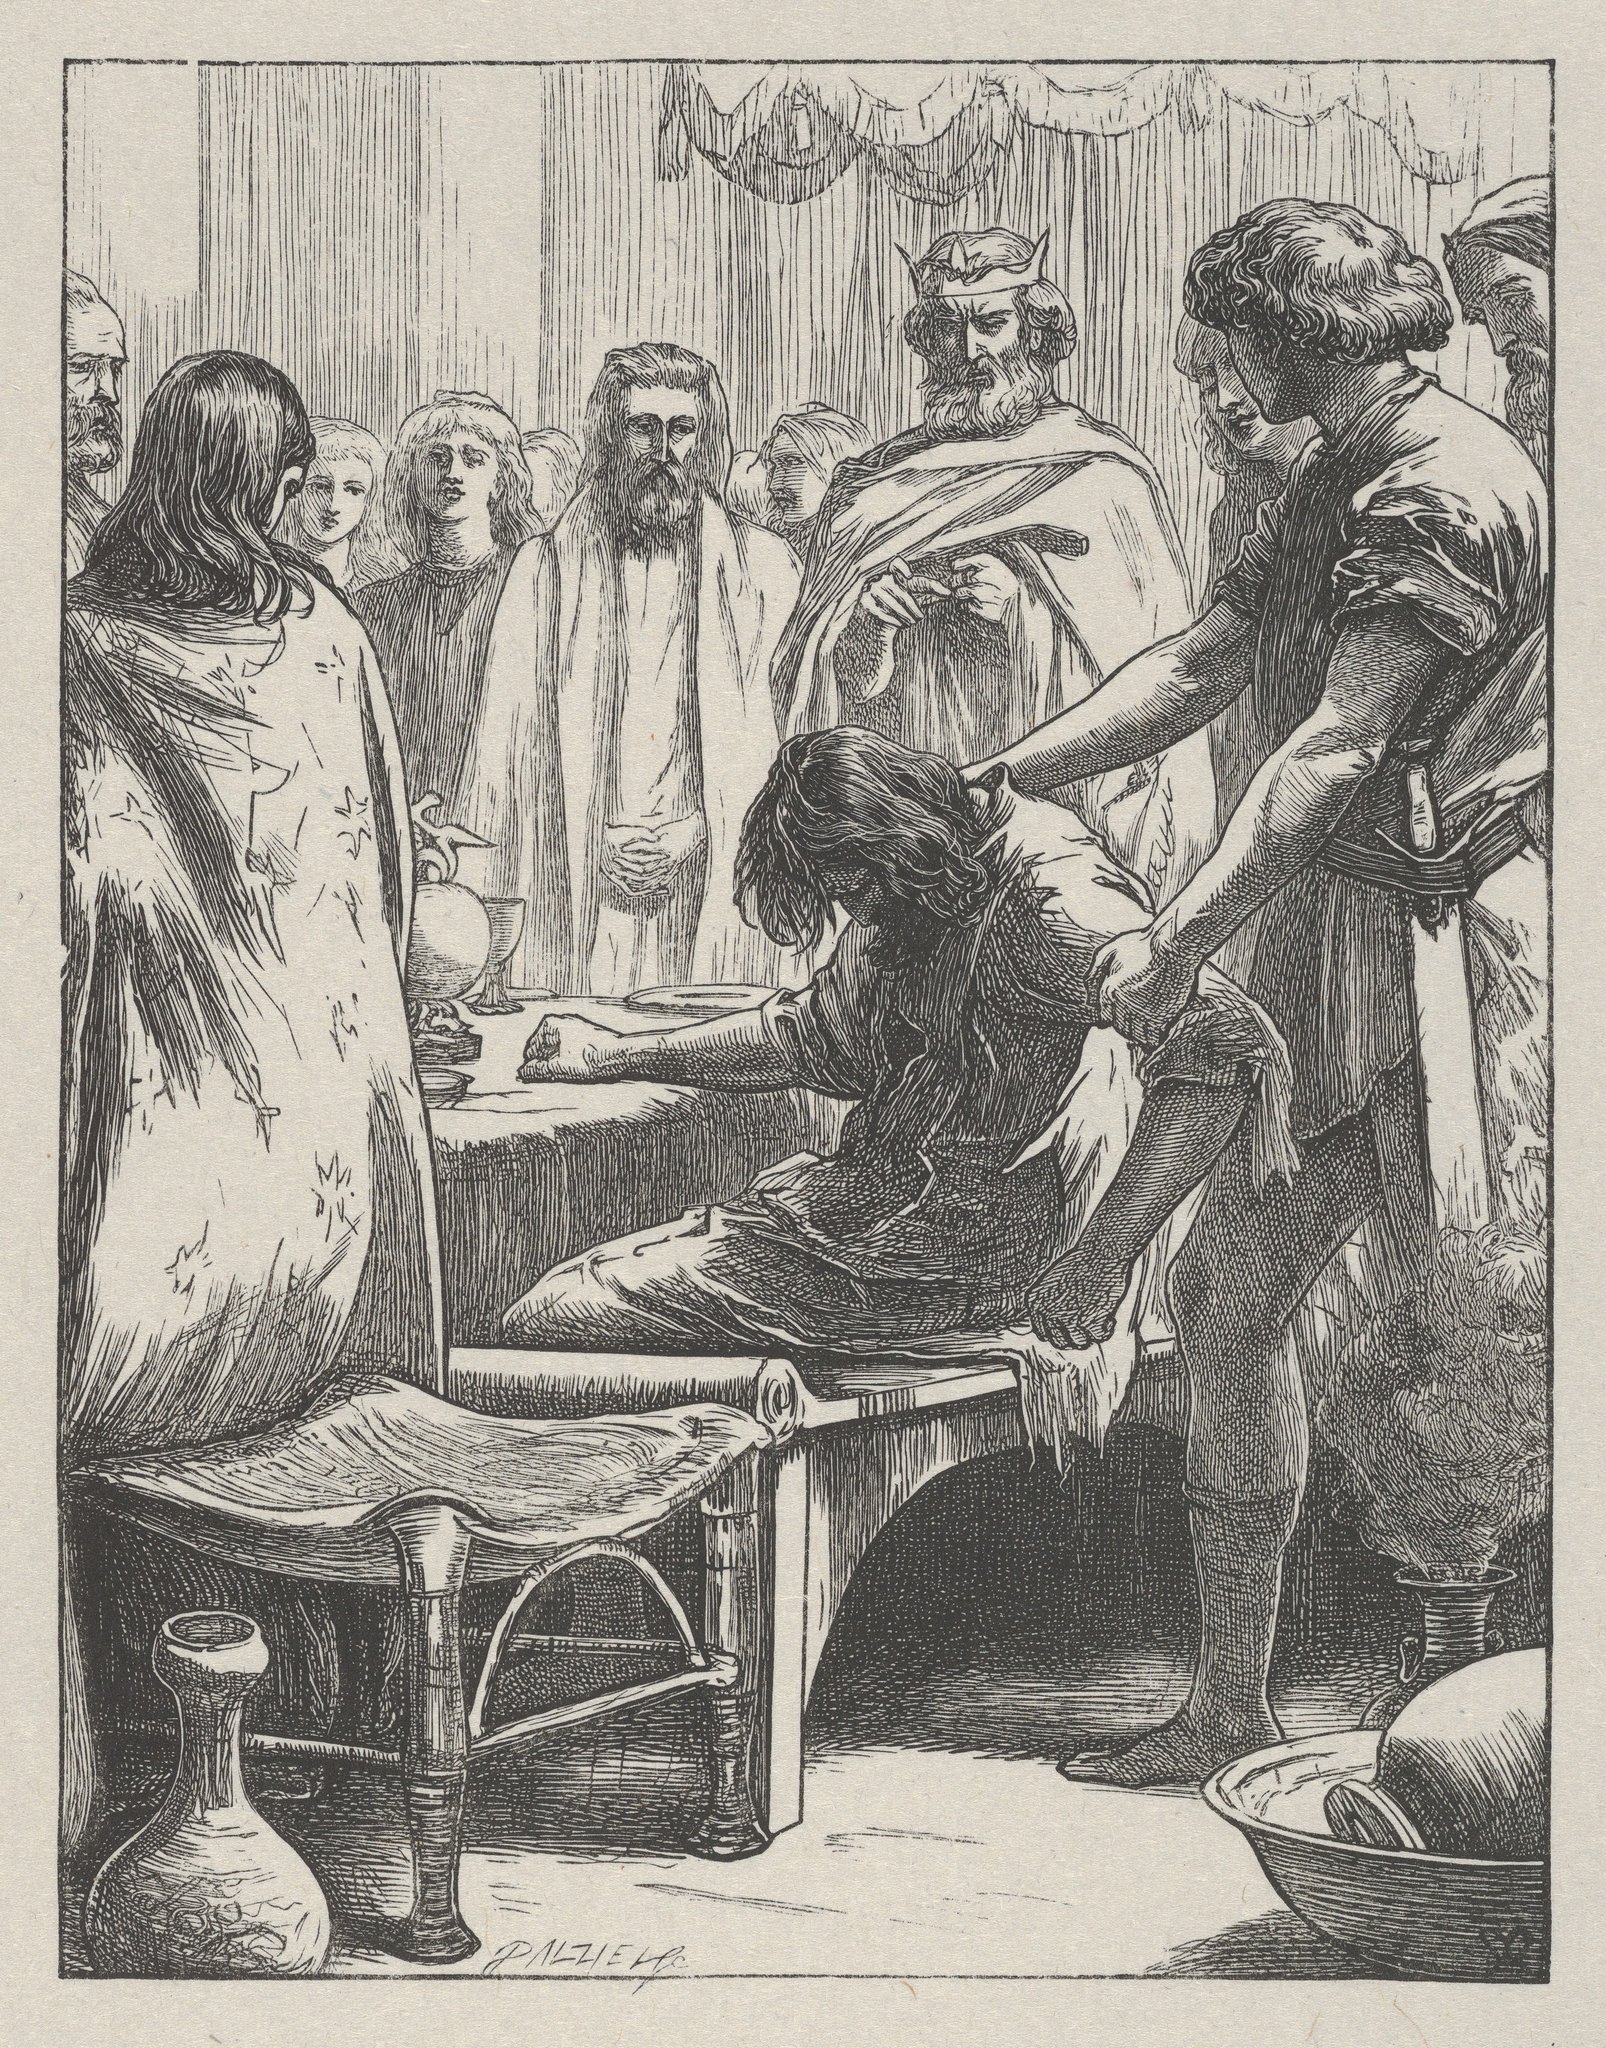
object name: print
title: The Marriage Feast (The Parables of Our Lord and Saviour Jesus Christ)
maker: sir john everett millais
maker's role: artist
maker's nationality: british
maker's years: 1829-1896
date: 1864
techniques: engraving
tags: men,women,christ